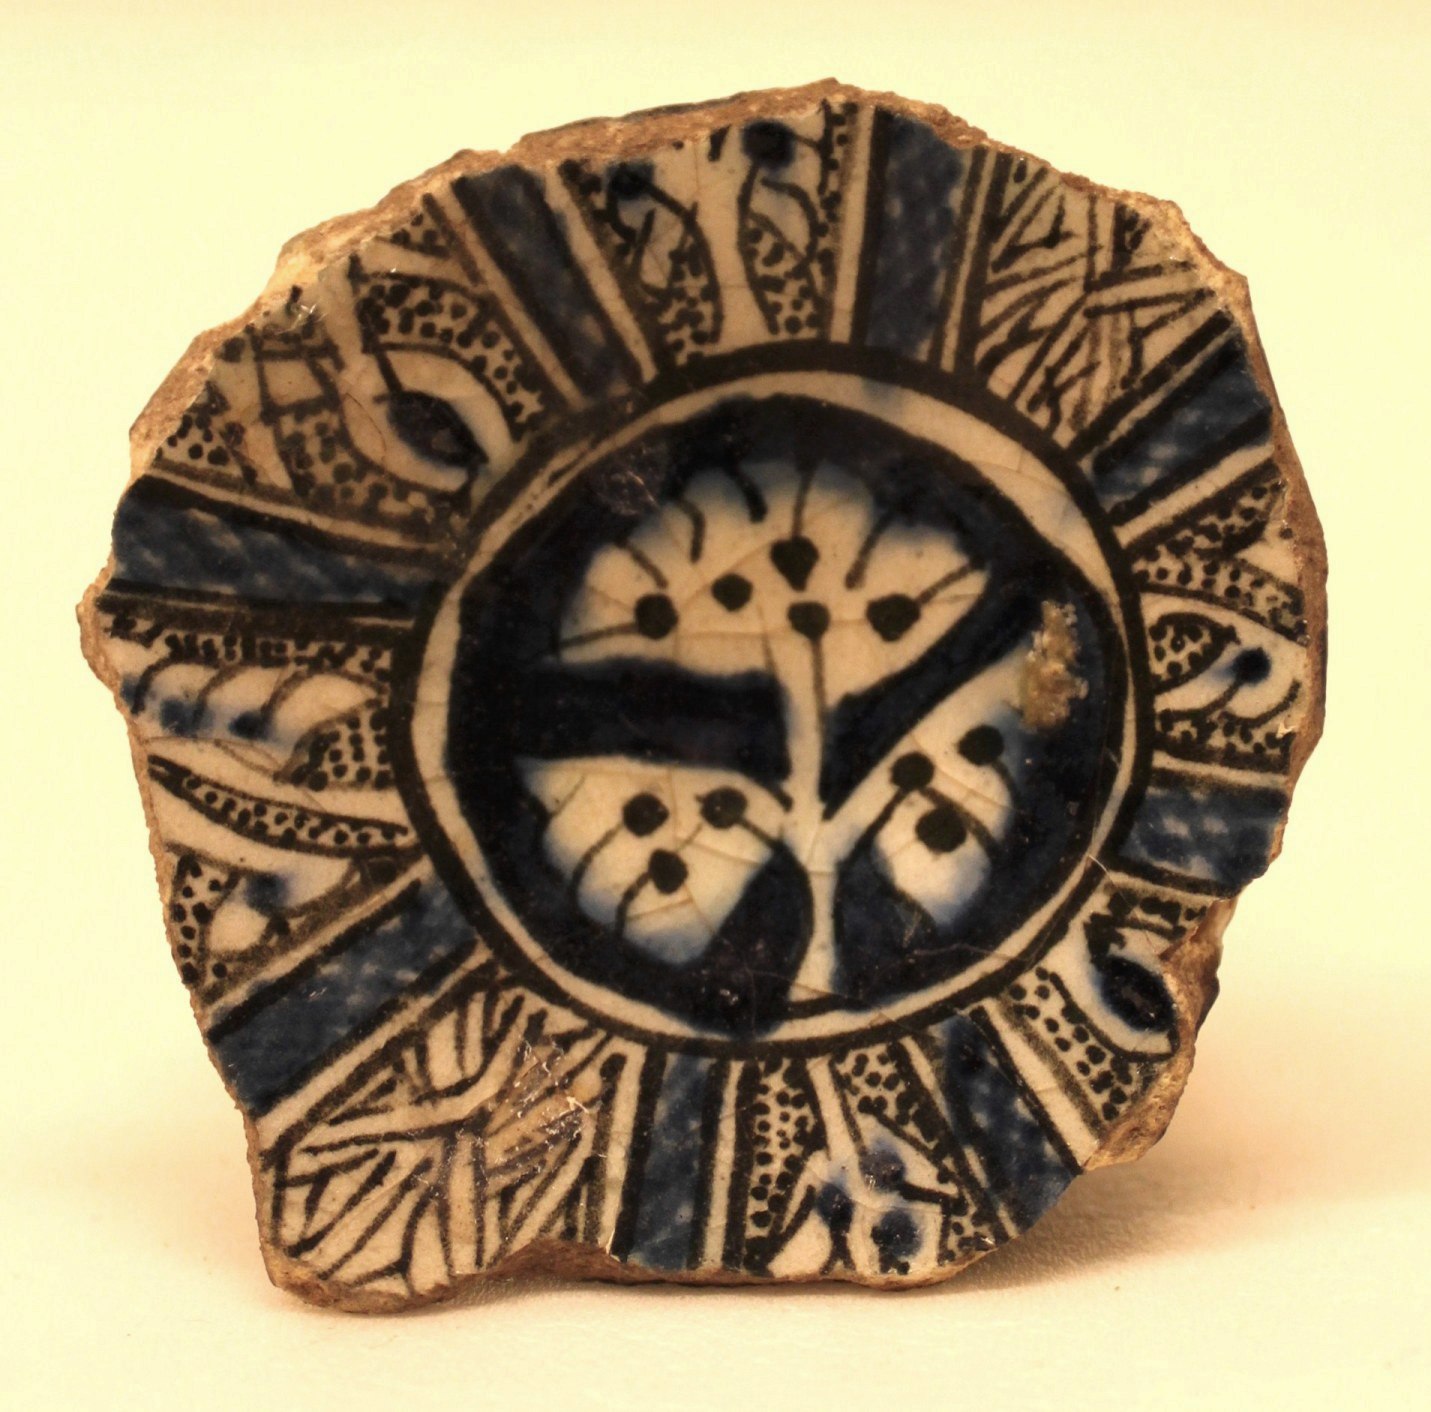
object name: fragment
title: Fragment of a Bowl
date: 1301-1500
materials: glaze, stonepaste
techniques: painting, polychrome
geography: egypt